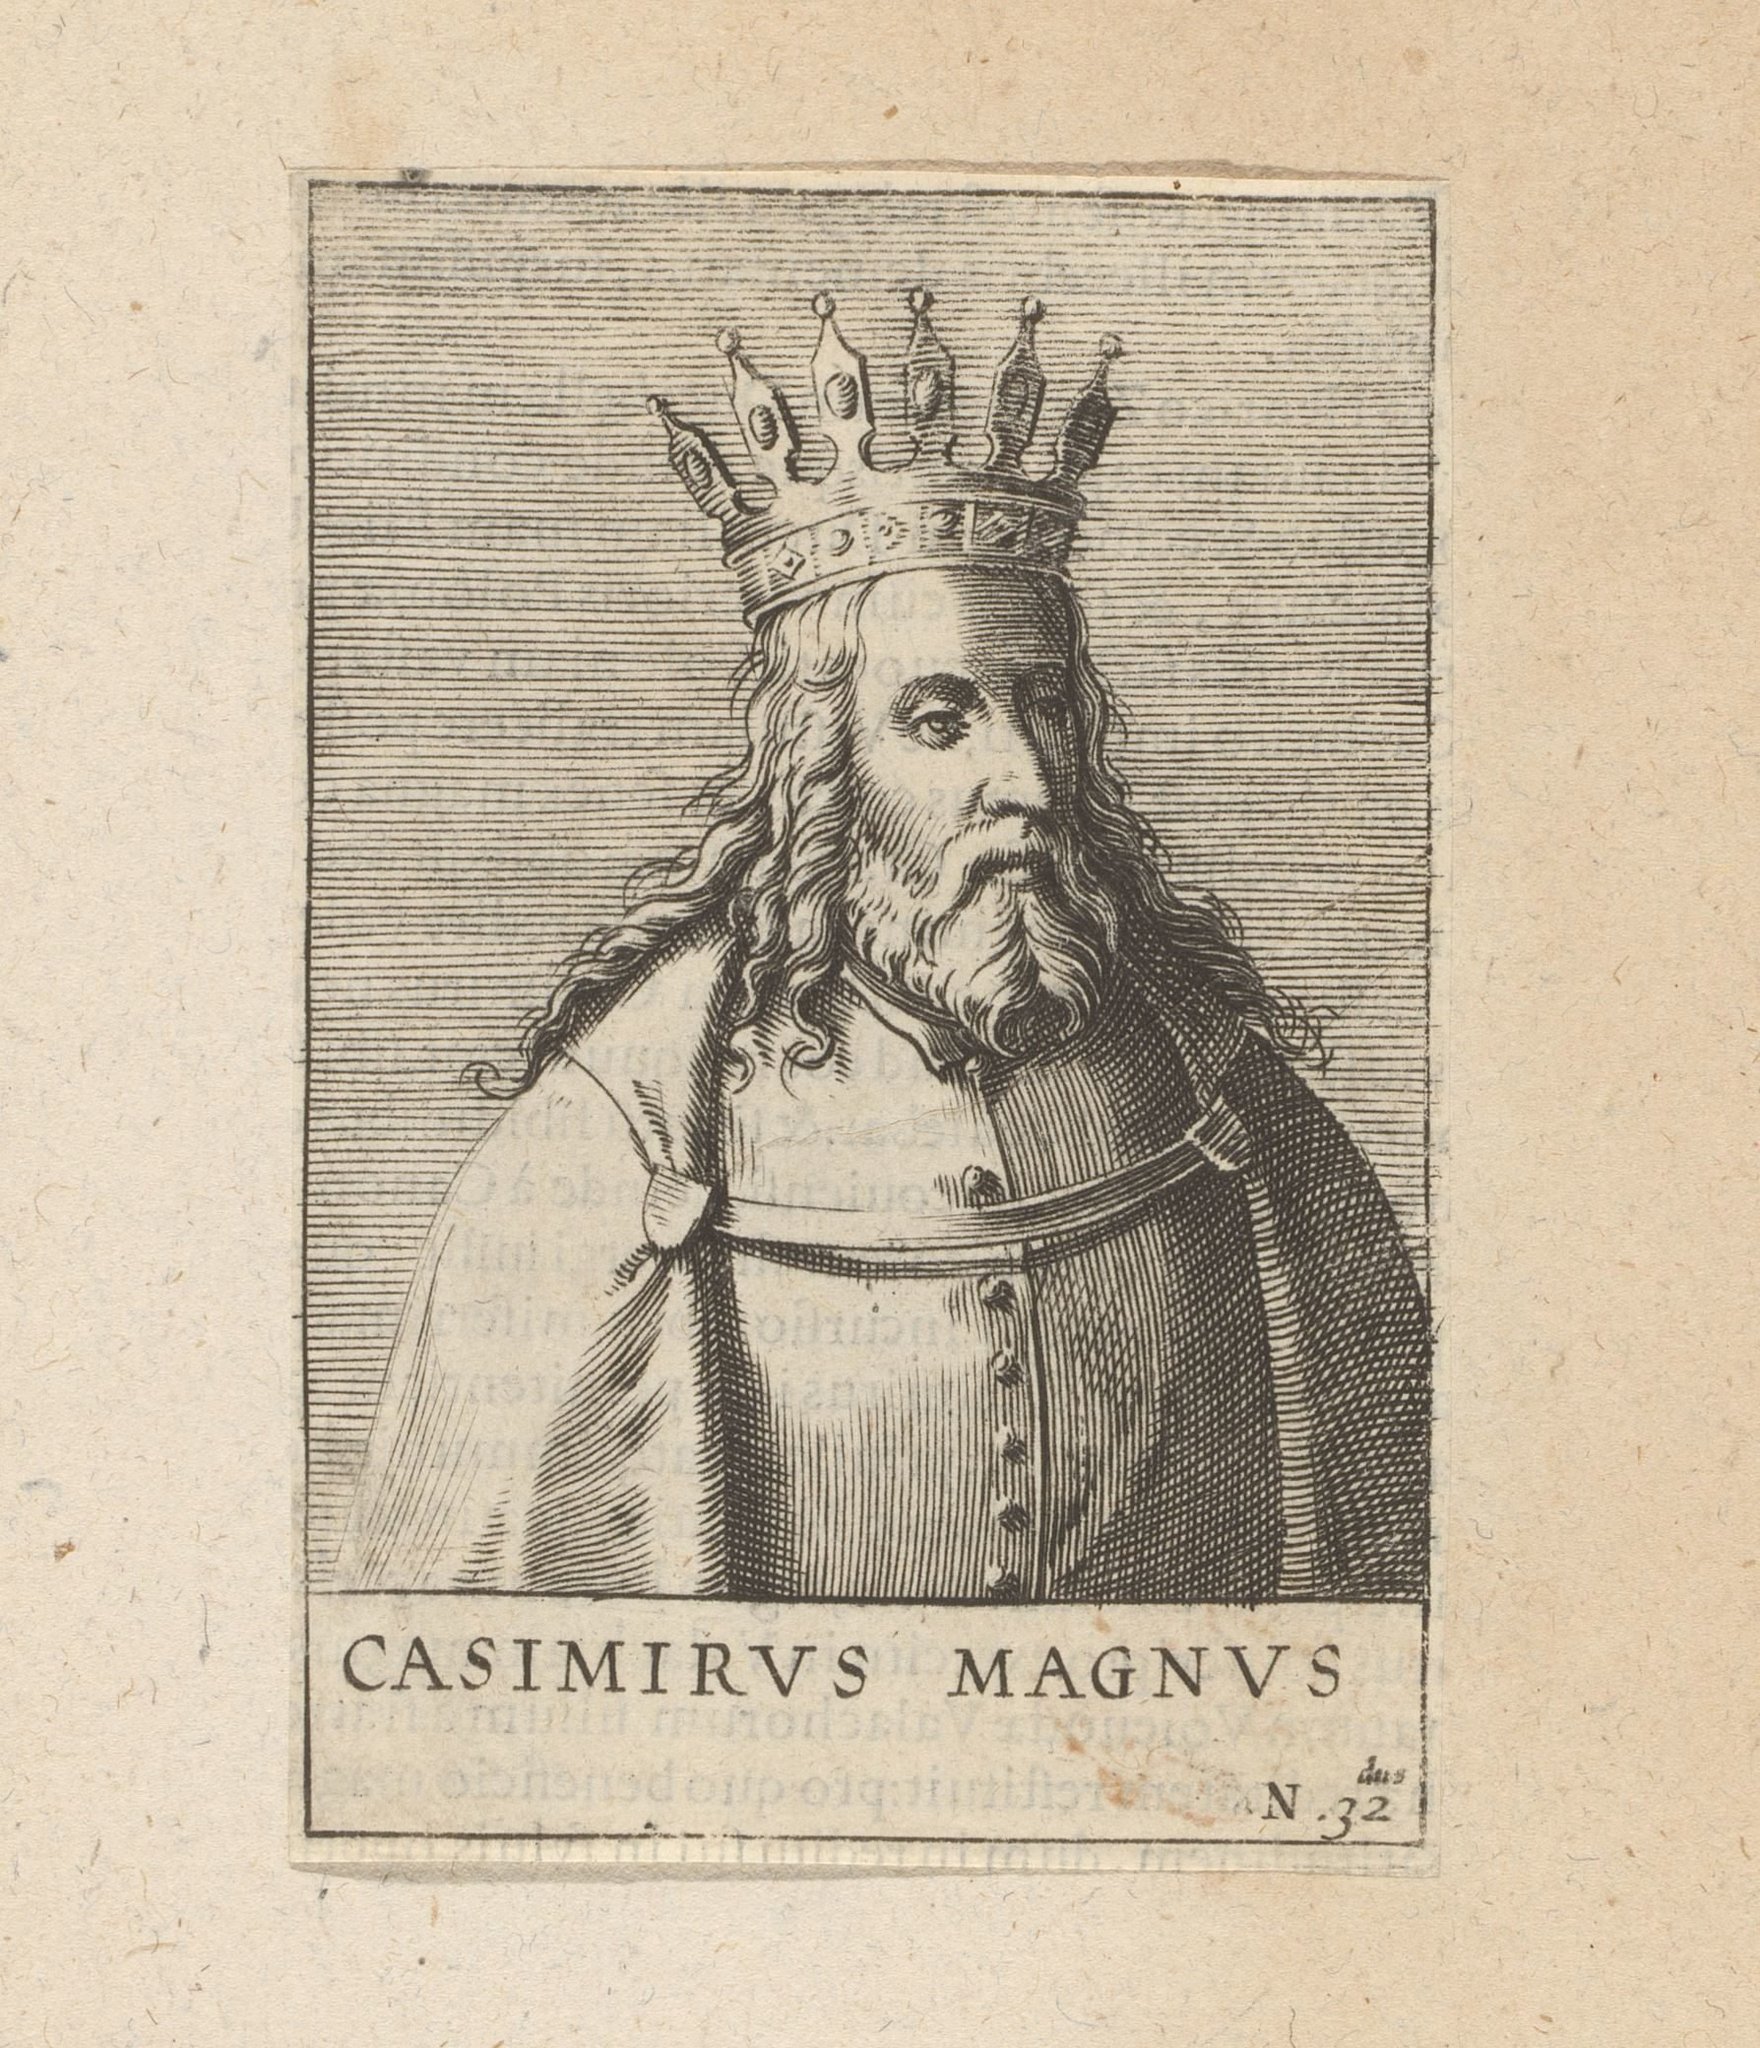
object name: print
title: Portret van Casimir de Grote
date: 1574-1594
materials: paper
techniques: woodcut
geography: cologne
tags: historical persons, king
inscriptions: collector's mark: Lugt 240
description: Prent gebruikt in: Mylius, Arnold. Principum et Regum Polonorum Imagines ad Vivum Expressae (...). Keulen: Gottfried von Kempen, 1594.